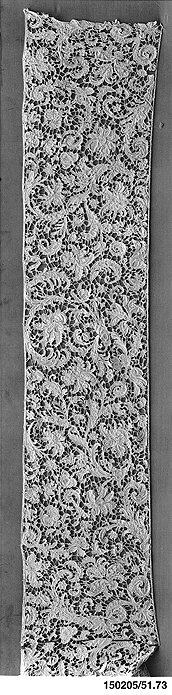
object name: flounce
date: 1601-1700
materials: lace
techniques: gros point, lace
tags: flowers